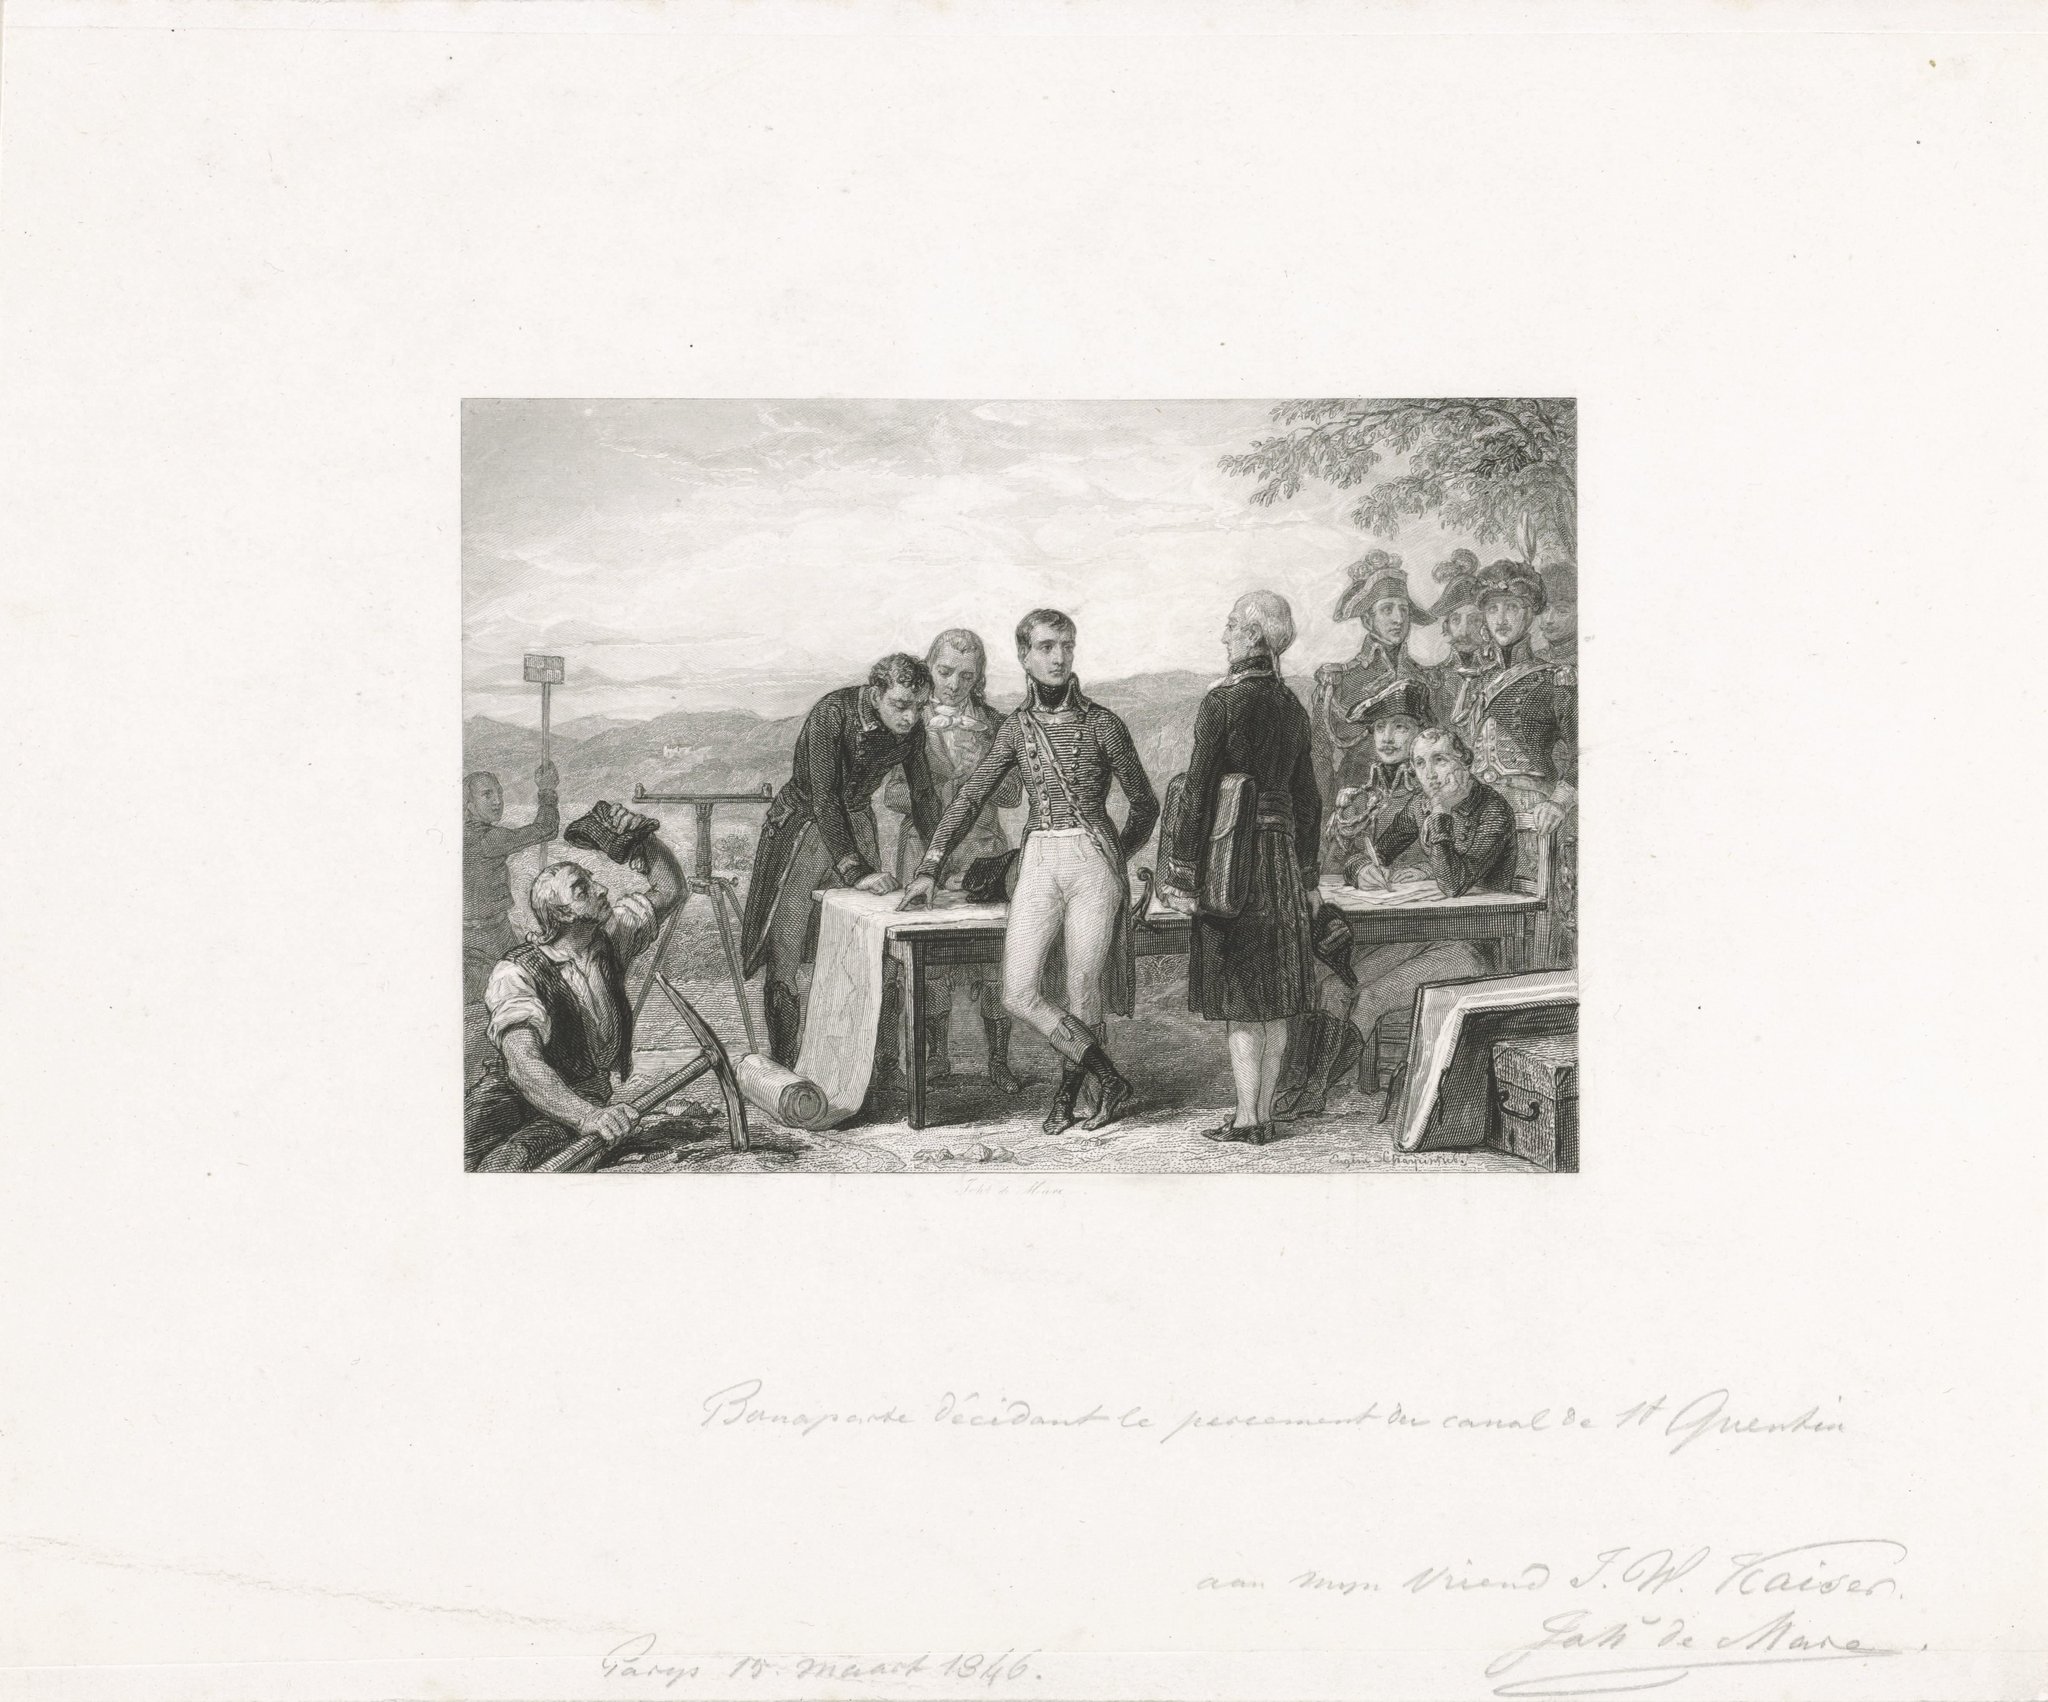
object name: print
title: Napoleon besluit tot de doorbraak van het Canal de Saint-Quentin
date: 1816-1846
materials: paper, pencil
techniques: engraving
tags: napoleon i (emperor of the french)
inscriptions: date: ‘Parijs 15 maart 1846’, collector's mark: Lugt 2228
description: Napoleon I Bonaparte met zijn hand op een kaart naast hem op een tafel, omringd door vele heren. Links gravers. Het Canal de Saint-Quentin werd op 28 april 1810 door Napoleon geopend. Het betrof hier de eerste verbinding tussen de Seine en de Schelde.